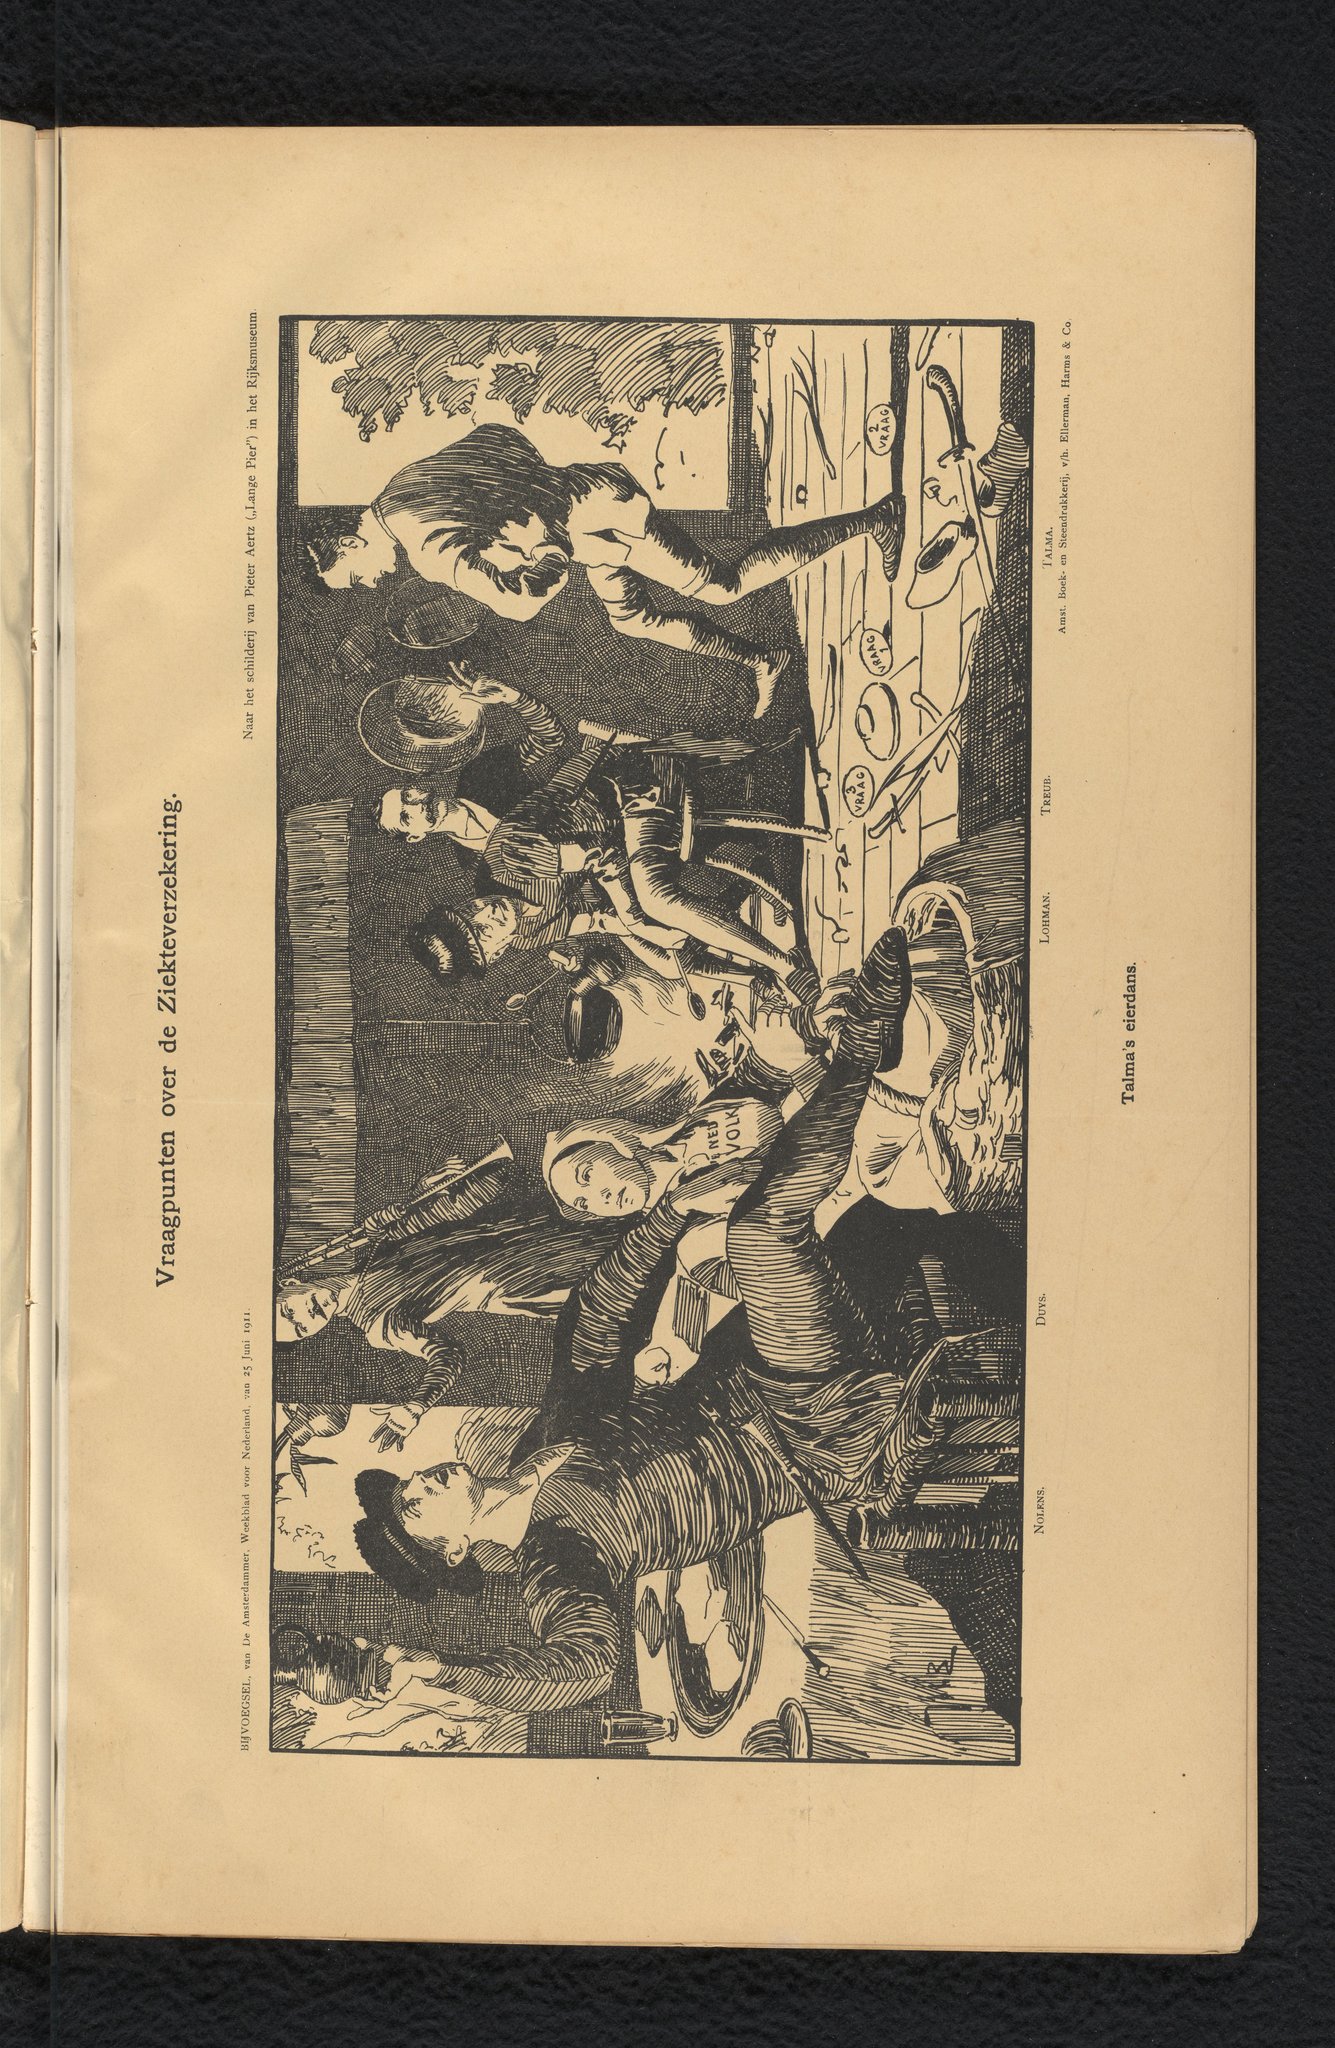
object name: cartoon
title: Vraagpunten over de Ziekteverzekering / Talma's eierdans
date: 1911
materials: paper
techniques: lithograph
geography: netherlands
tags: nijmegen, amsterdam, jonkheer alexander frederik de savornin lohman, priest, voorschoten, the hague, kitchen, personifications of countries, nations, states, districts, etc., man dancing alone, festivities (+ games of skill ~ festive activities), political caricatures and satires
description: Minister Talma danst de eierdans. De Nederlandse Maagd, Nolens, Duijs, Lohman en Treub kijken toe. Naar het schilderij 'De Eierdans' van Pieter Aertsen.